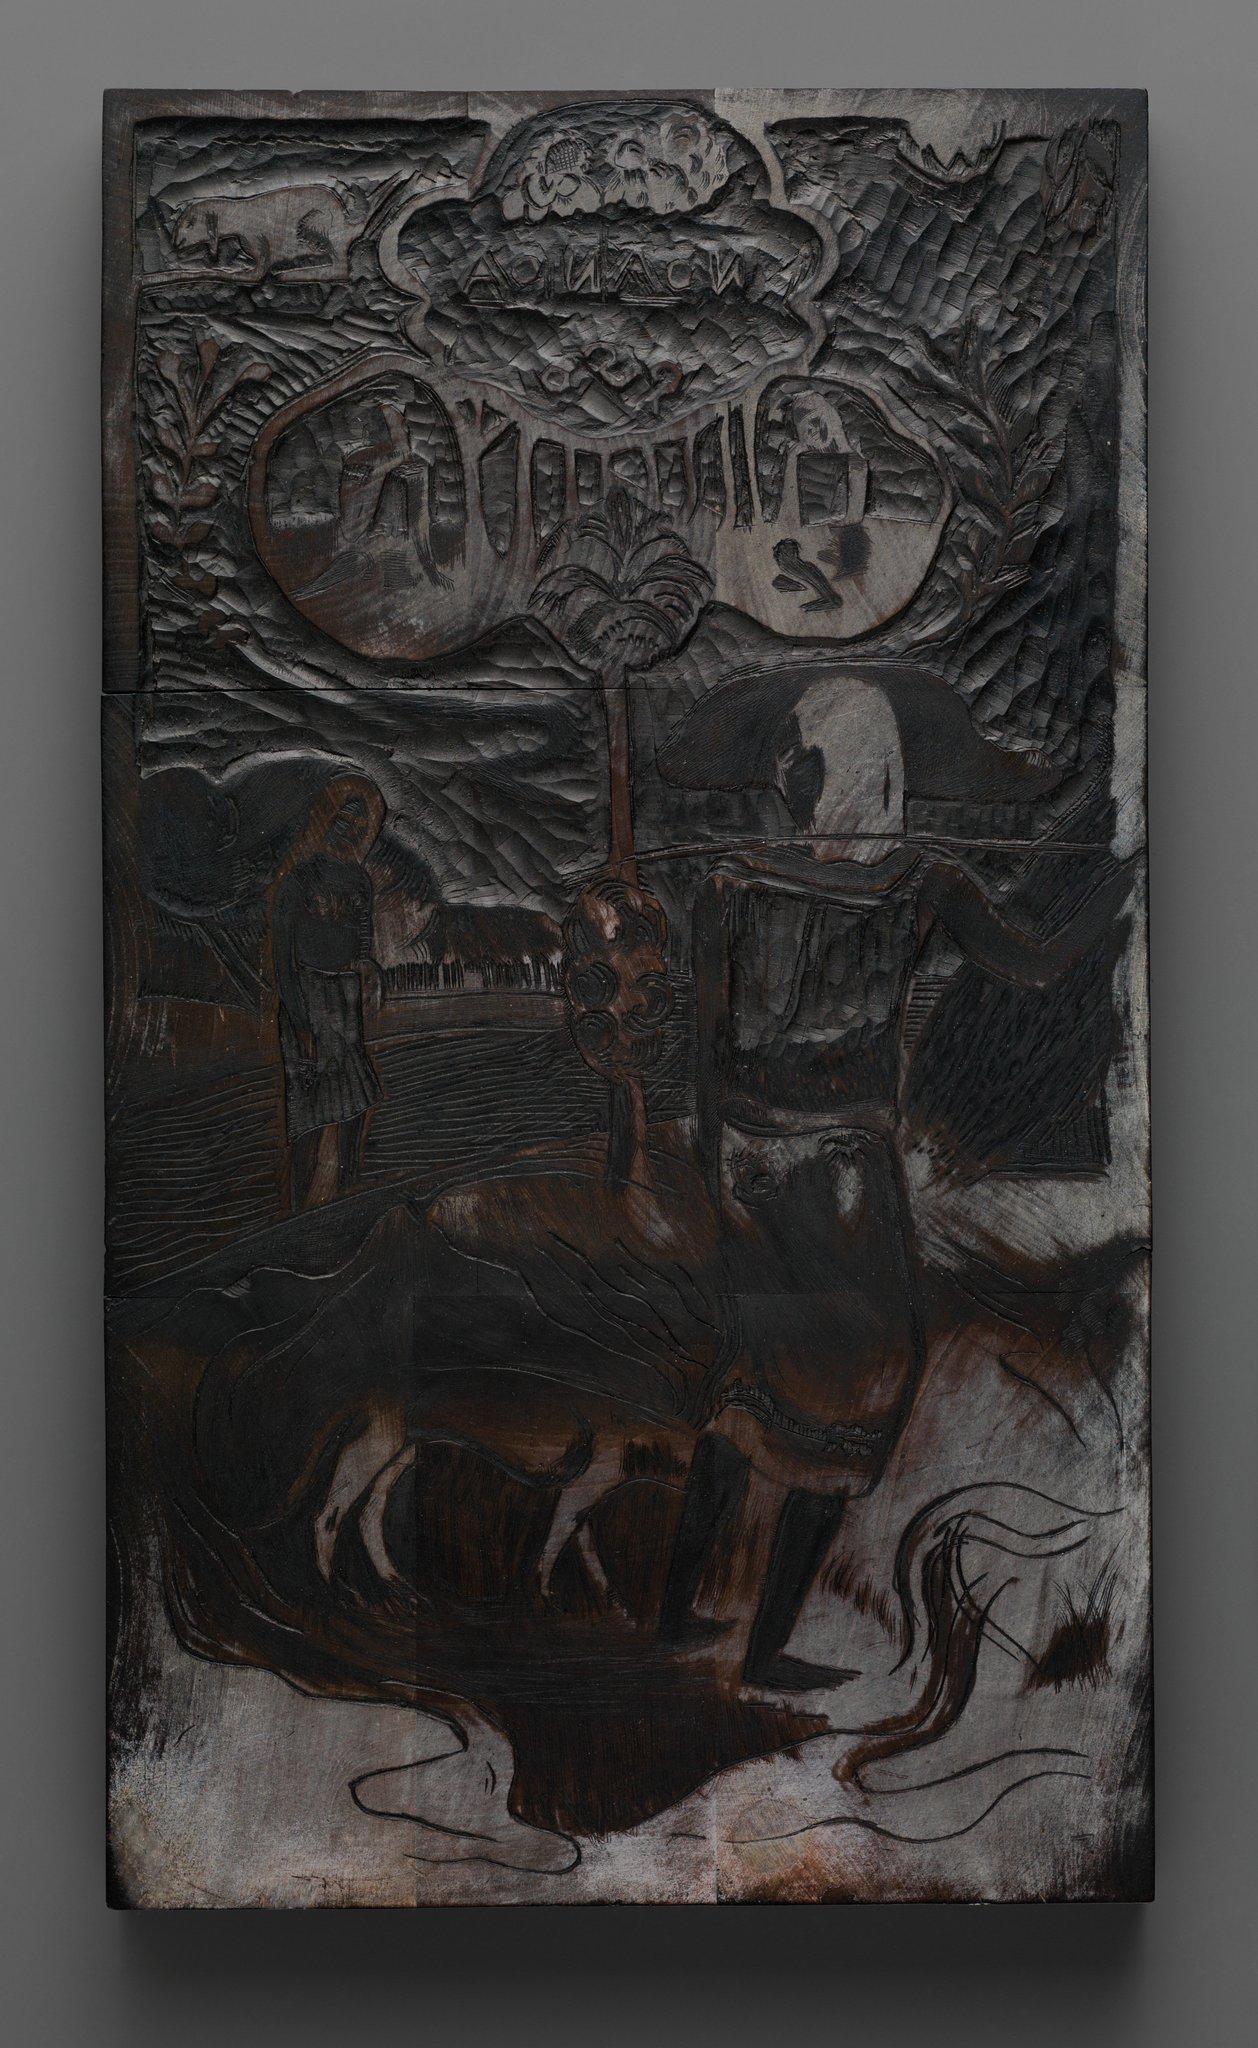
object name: block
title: Fragrance (Noa Noa), from Fragrance (Noa Noa), title block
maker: paul gauguin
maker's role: artist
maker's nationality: french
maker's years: 1848-1903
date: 1893-1894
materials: ink, wood, zinc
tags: animals,women,trees